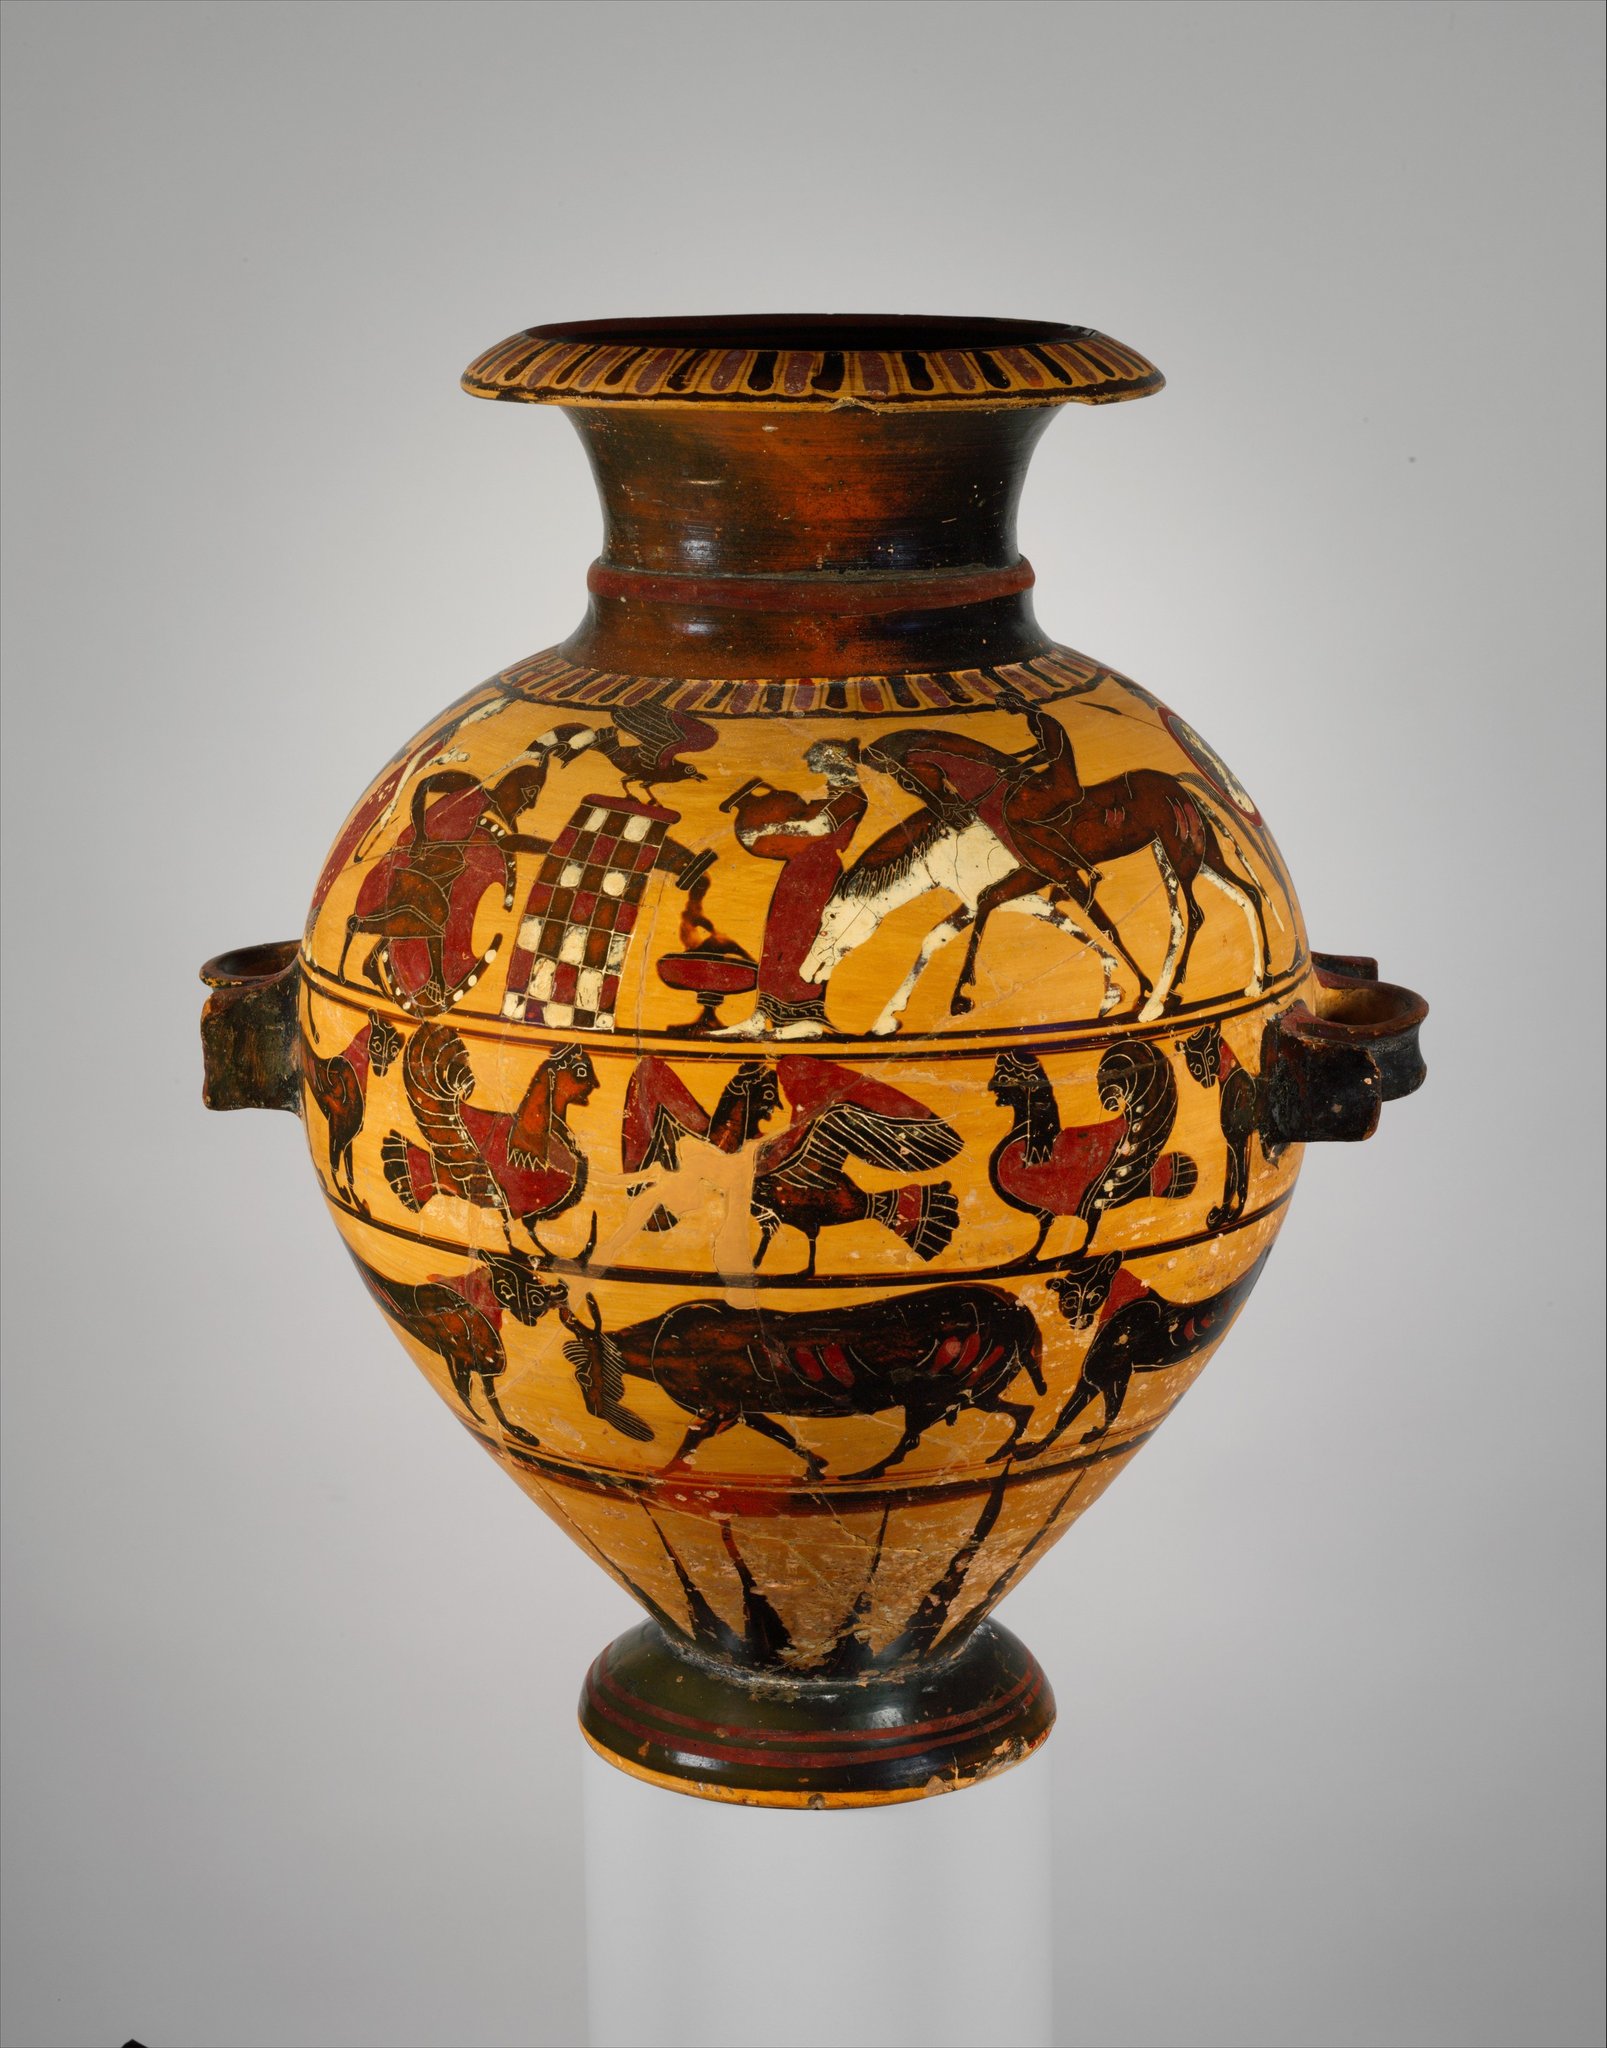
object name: hydria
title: Terracotta hydria (water jar)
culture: greek, attic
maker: painter of london b 76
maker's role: artist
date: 560-550 BCE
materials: terracotta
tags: animals,birds,trojan war,achilles,horses